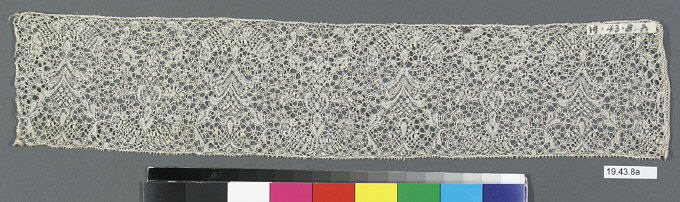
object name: piece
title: Piece (one of three)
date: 1701-1800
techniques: lace